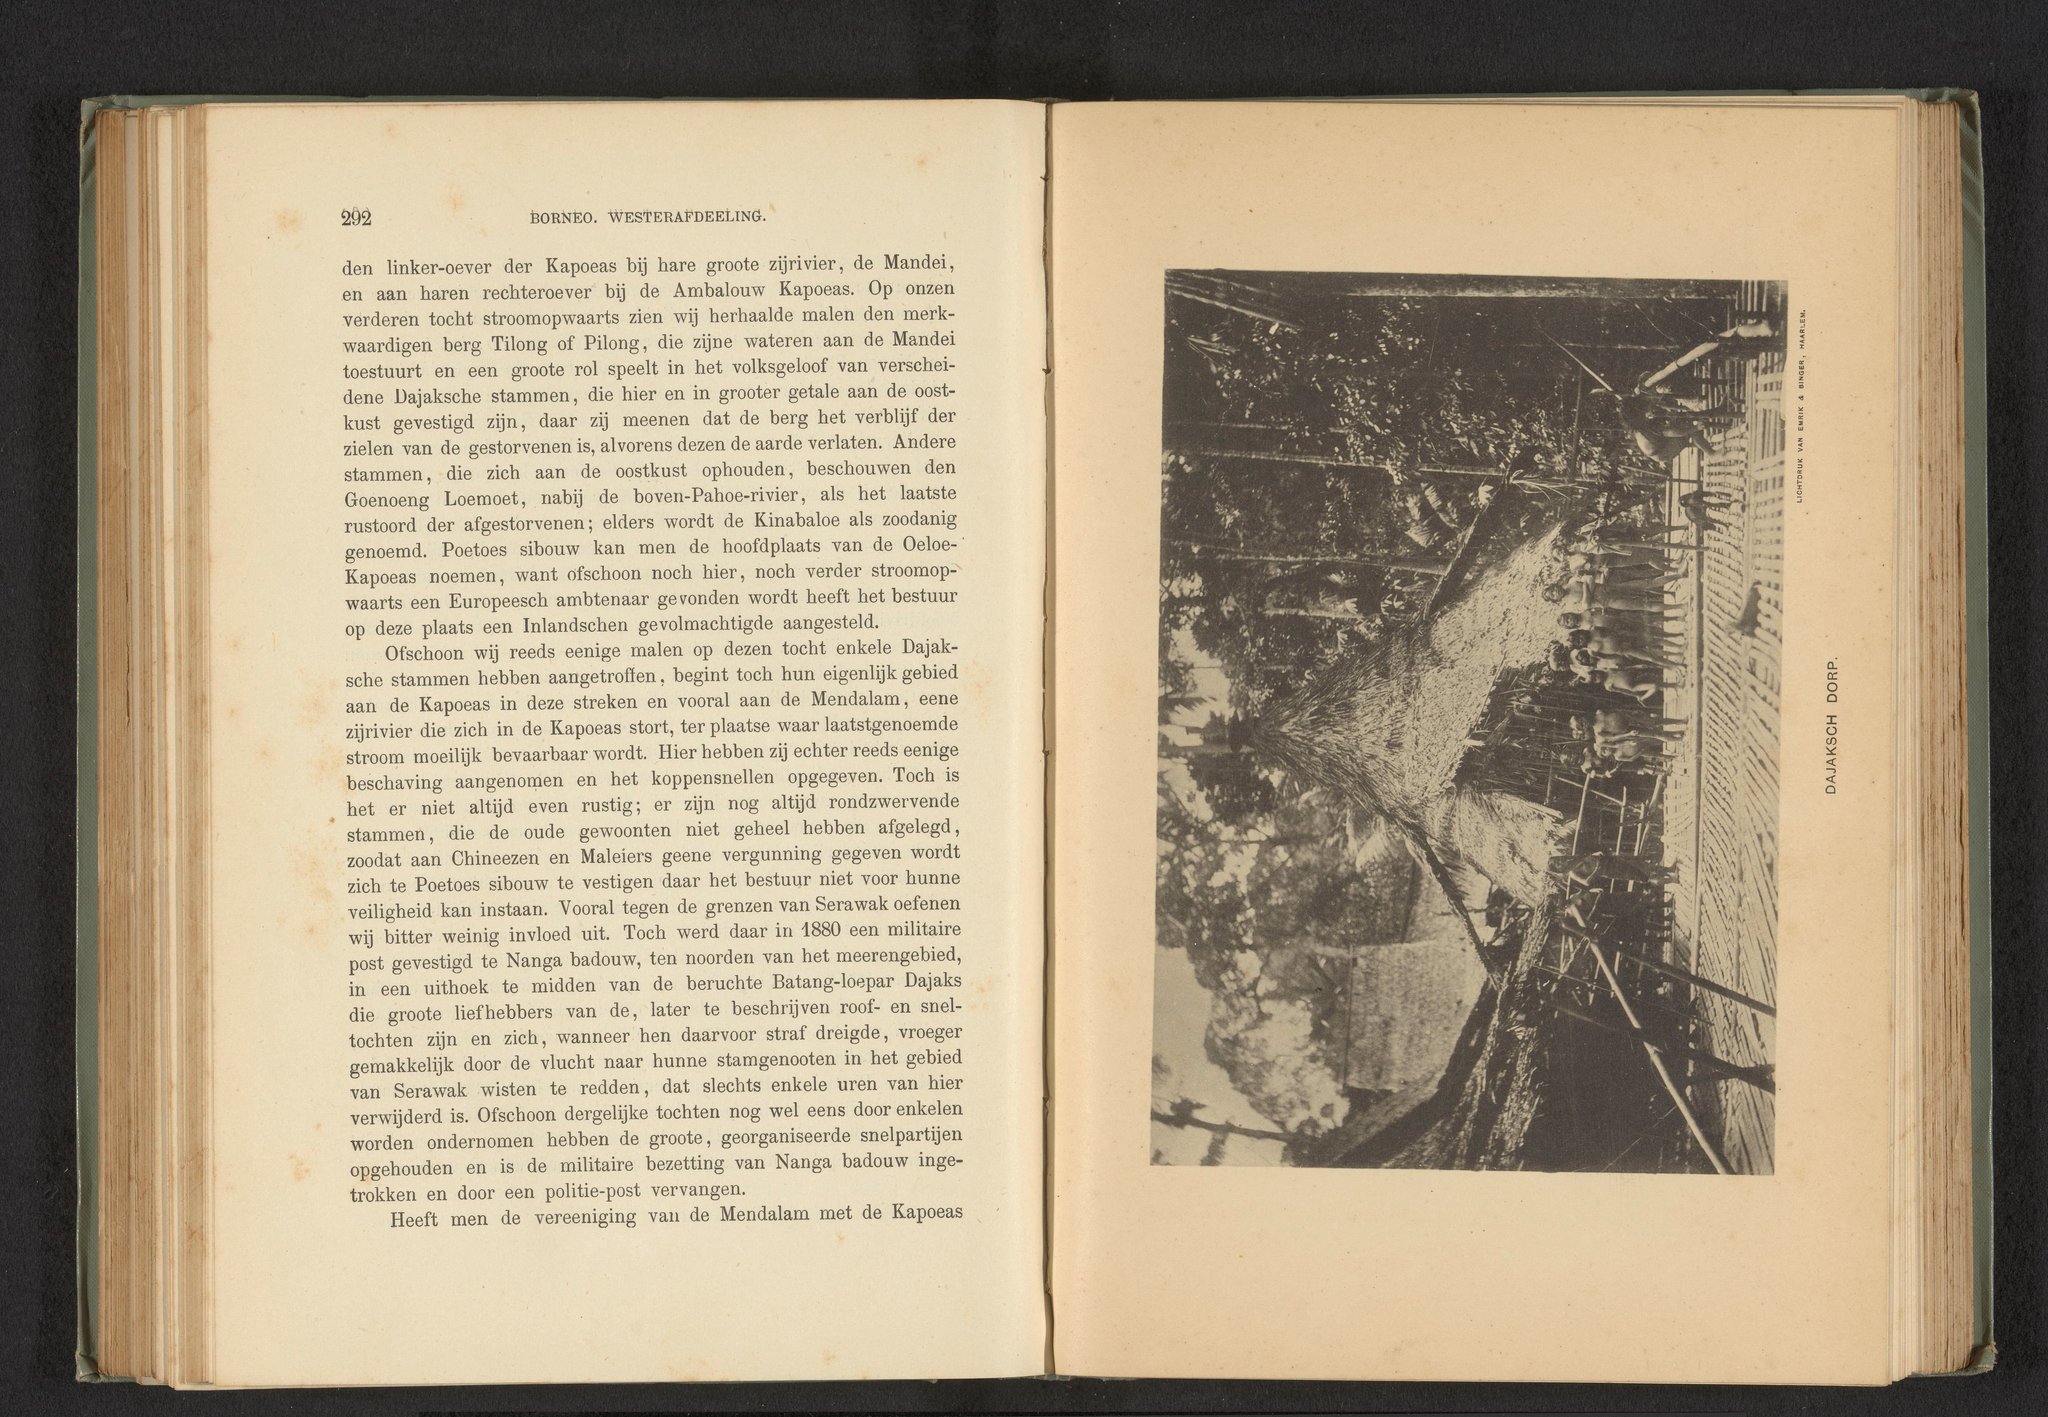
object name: photomechanical print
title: Gezicht op een dorp van een Dajakvolk op Borneo met kinderen voor een huis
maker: Anonymous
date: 1883-1894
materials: paper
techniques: photograph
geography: borneo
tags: village, borneo